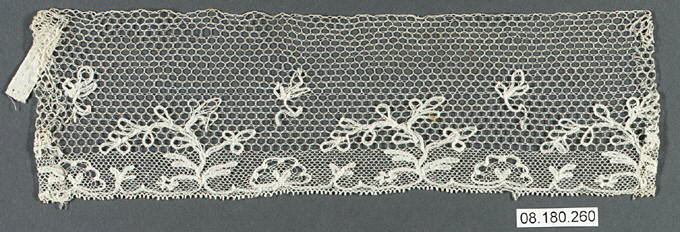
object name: fragment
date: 1701-1800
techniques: lace